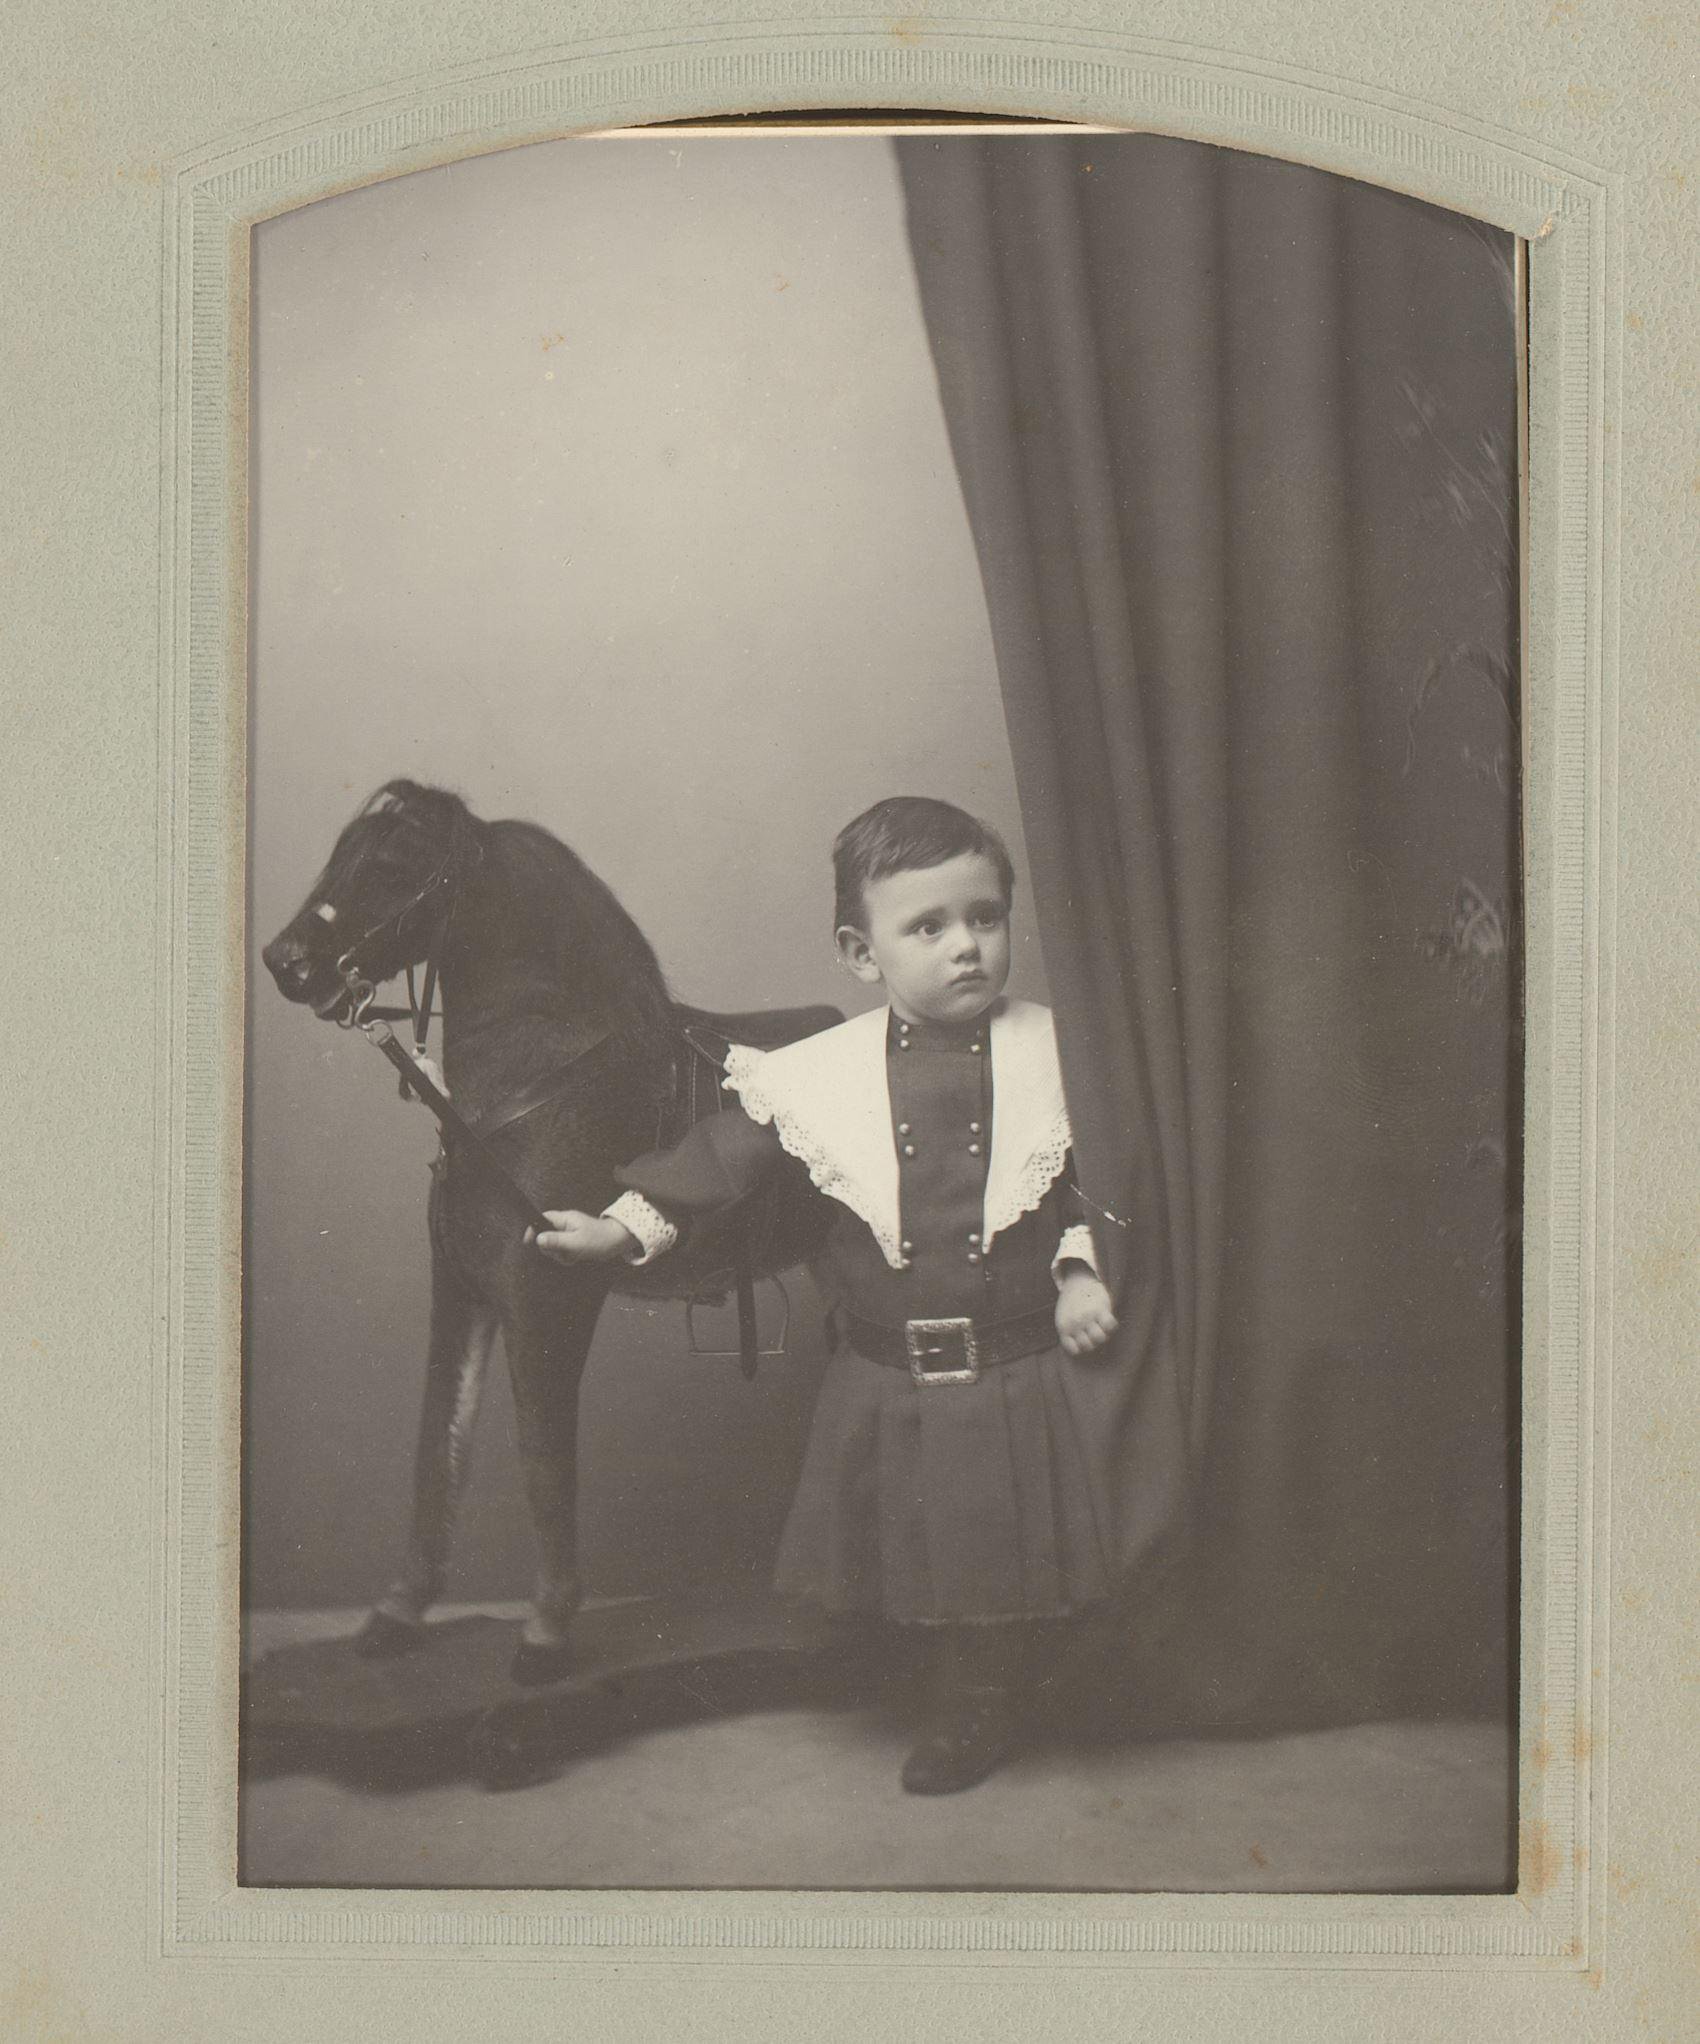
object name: cabinet photograph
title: Portret van een onbekend kind met hobbelpaard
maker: wilhelm holtorp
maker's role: fotograaf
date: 1900-1915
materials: paper, cardboard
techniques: gelatin silver print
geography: bremen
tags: anonymous historical person portrayed, tot, toddler ~ the ages of man, rocking-horse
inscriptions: monogram: ‘WH’, inscription: ‘Wilh. Holtorp/ Bremen/ Osterthorsteinweg 61./ Vegrösserungen bis Lebensgrösse./ Die Platte bleibt aufbewahrt.’, inscription: ‘Wilh. Holtorp/ Bremen, Osterthorsteinweg 61.’